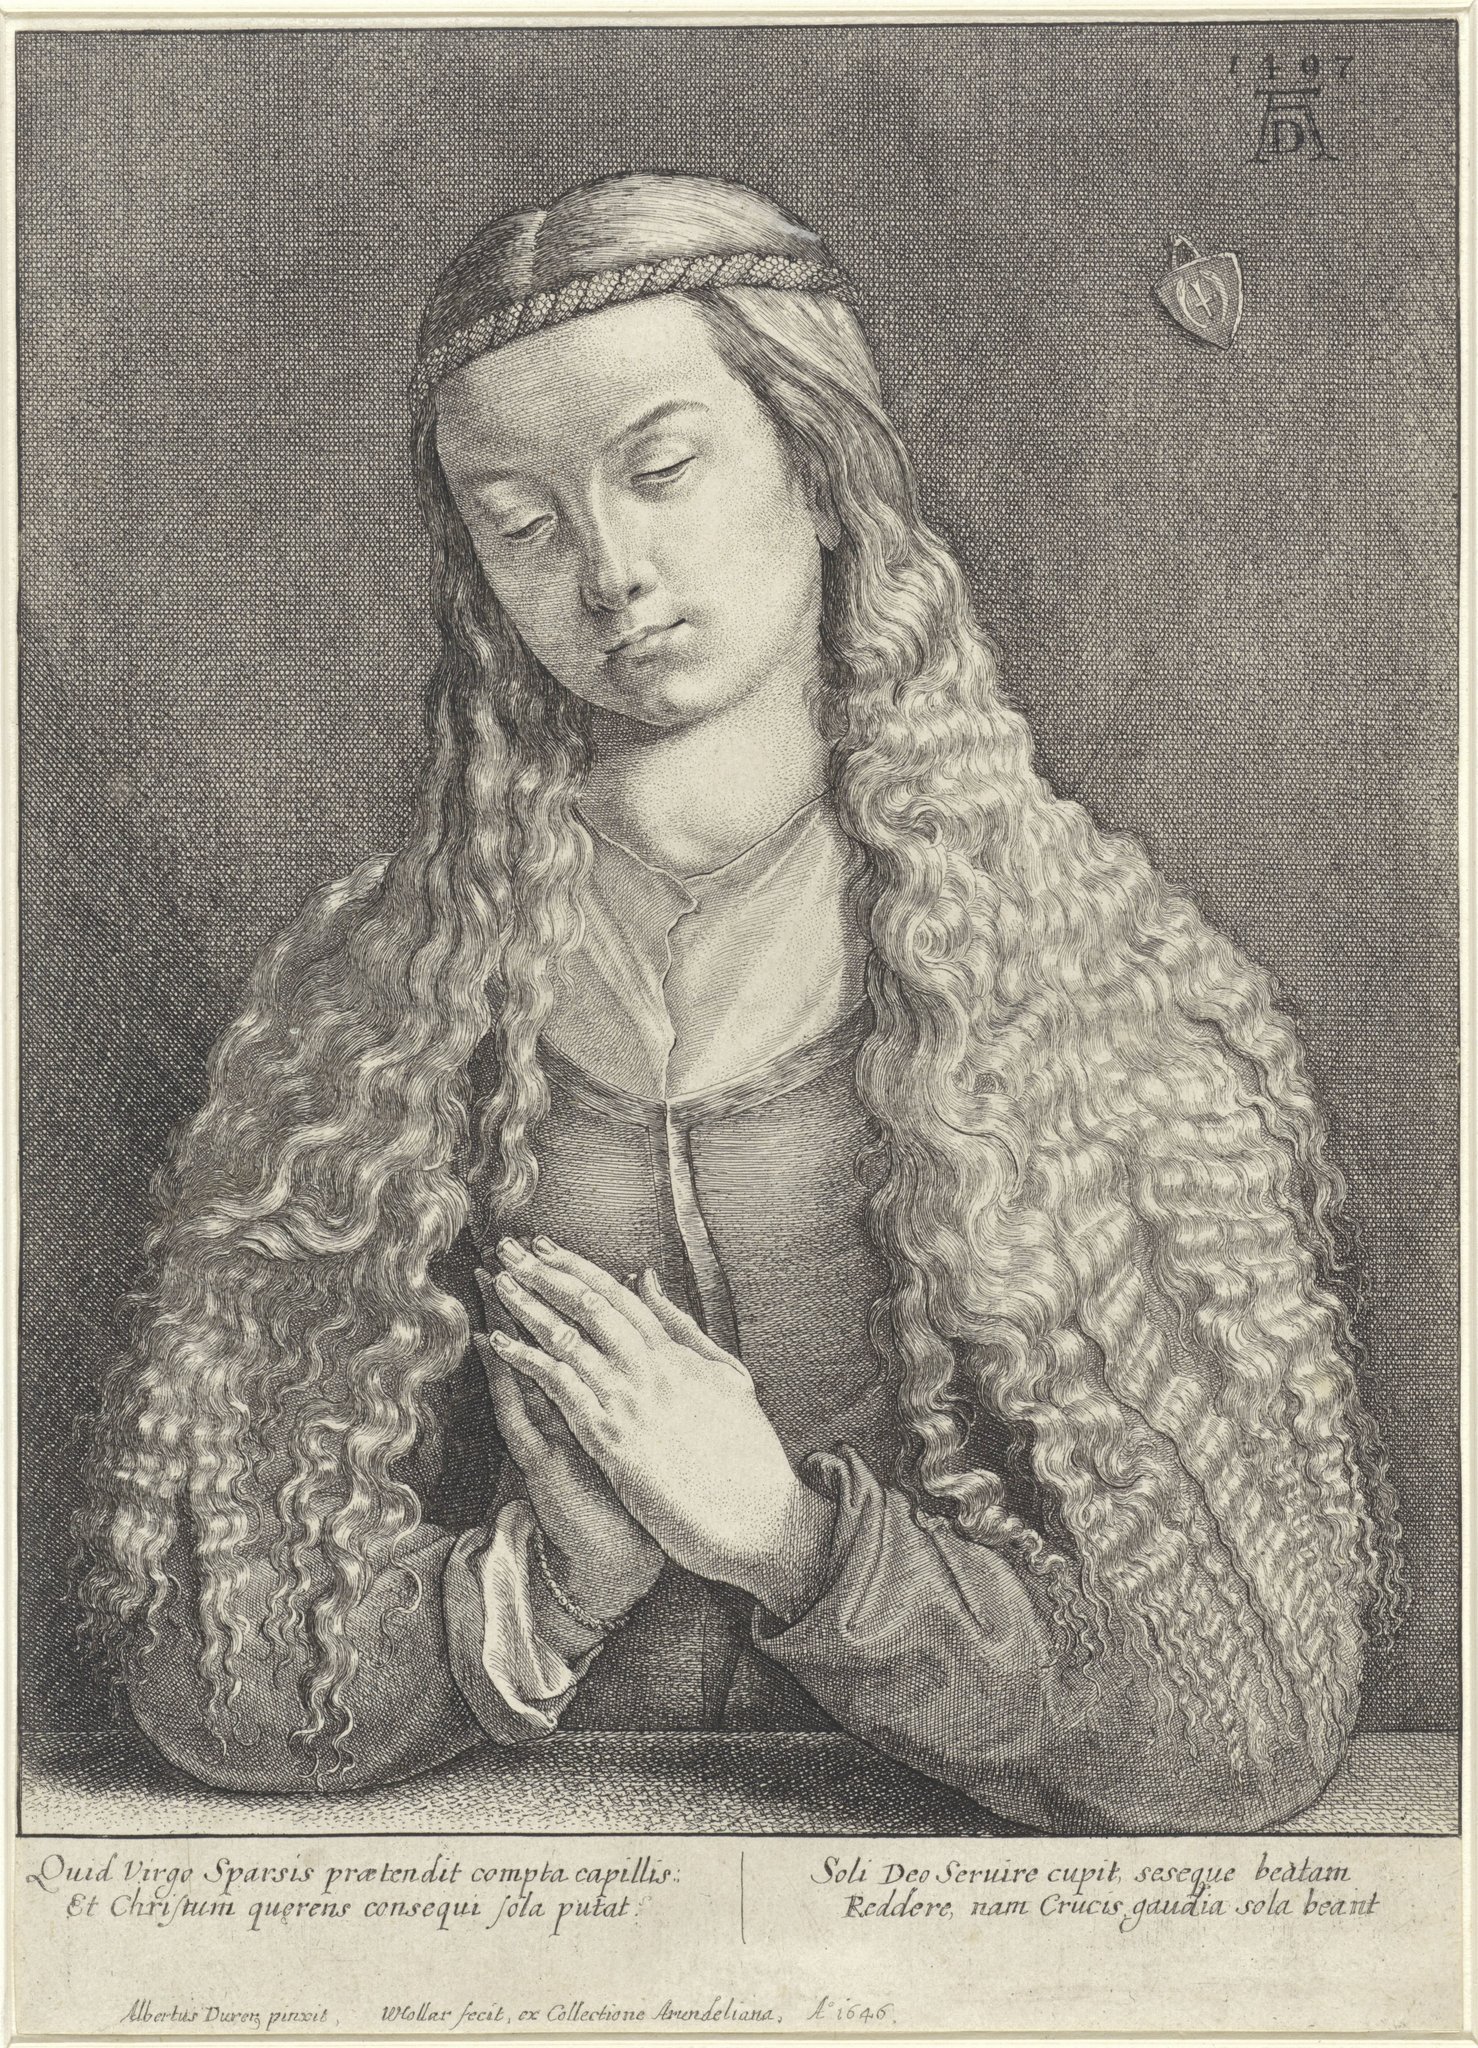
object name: print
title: Biddende vrouw met lang haar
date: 1646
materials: paper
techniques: etching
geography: antwerp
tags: one person praying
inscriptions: collector's mark: Lugt 384